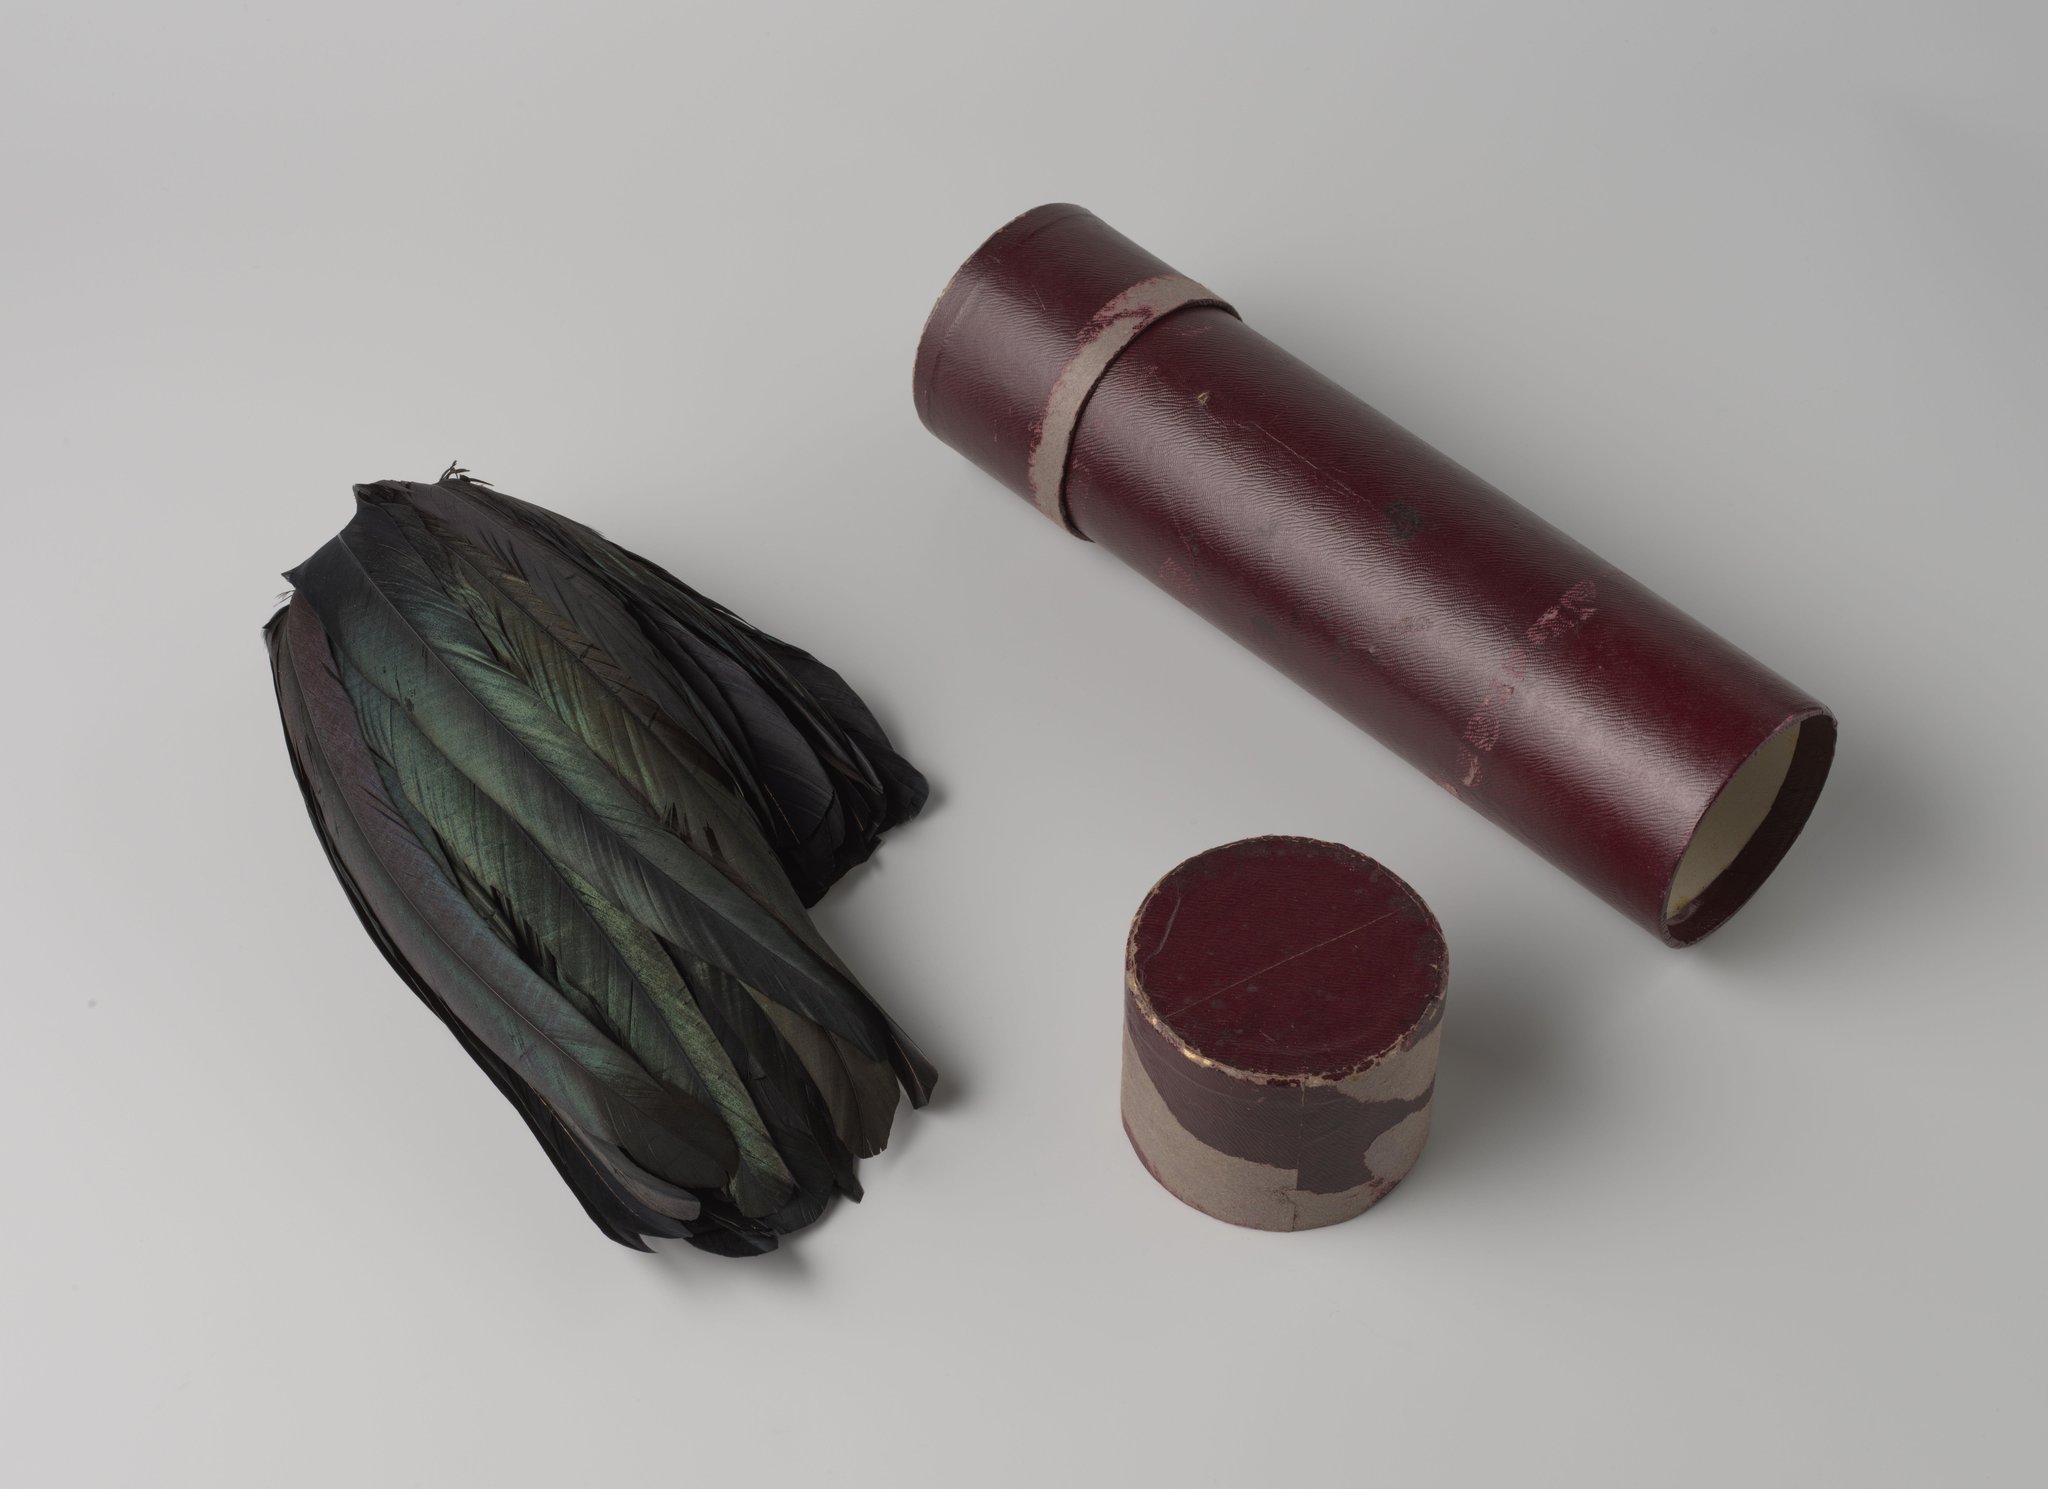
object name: plume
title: Pluim van zwarte haneveren, van een sjako van de Burgerwacht van Amsterdam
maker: Anonymous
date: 1934-1935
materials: copper, feather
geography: netherlands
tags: amsterdam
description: Pluim van zwarte haneveren (A), van een sjako van de 'burgerwacht' van Amsterdam. In donkerrode cilinderdoos (B) met aan beide zijden deksels. Op een koperen steel met reliëfpluimhouder is een bos zwarte haneveren gestoken, die vanuit de top neerhangen met een kort en een lang gedeelte.